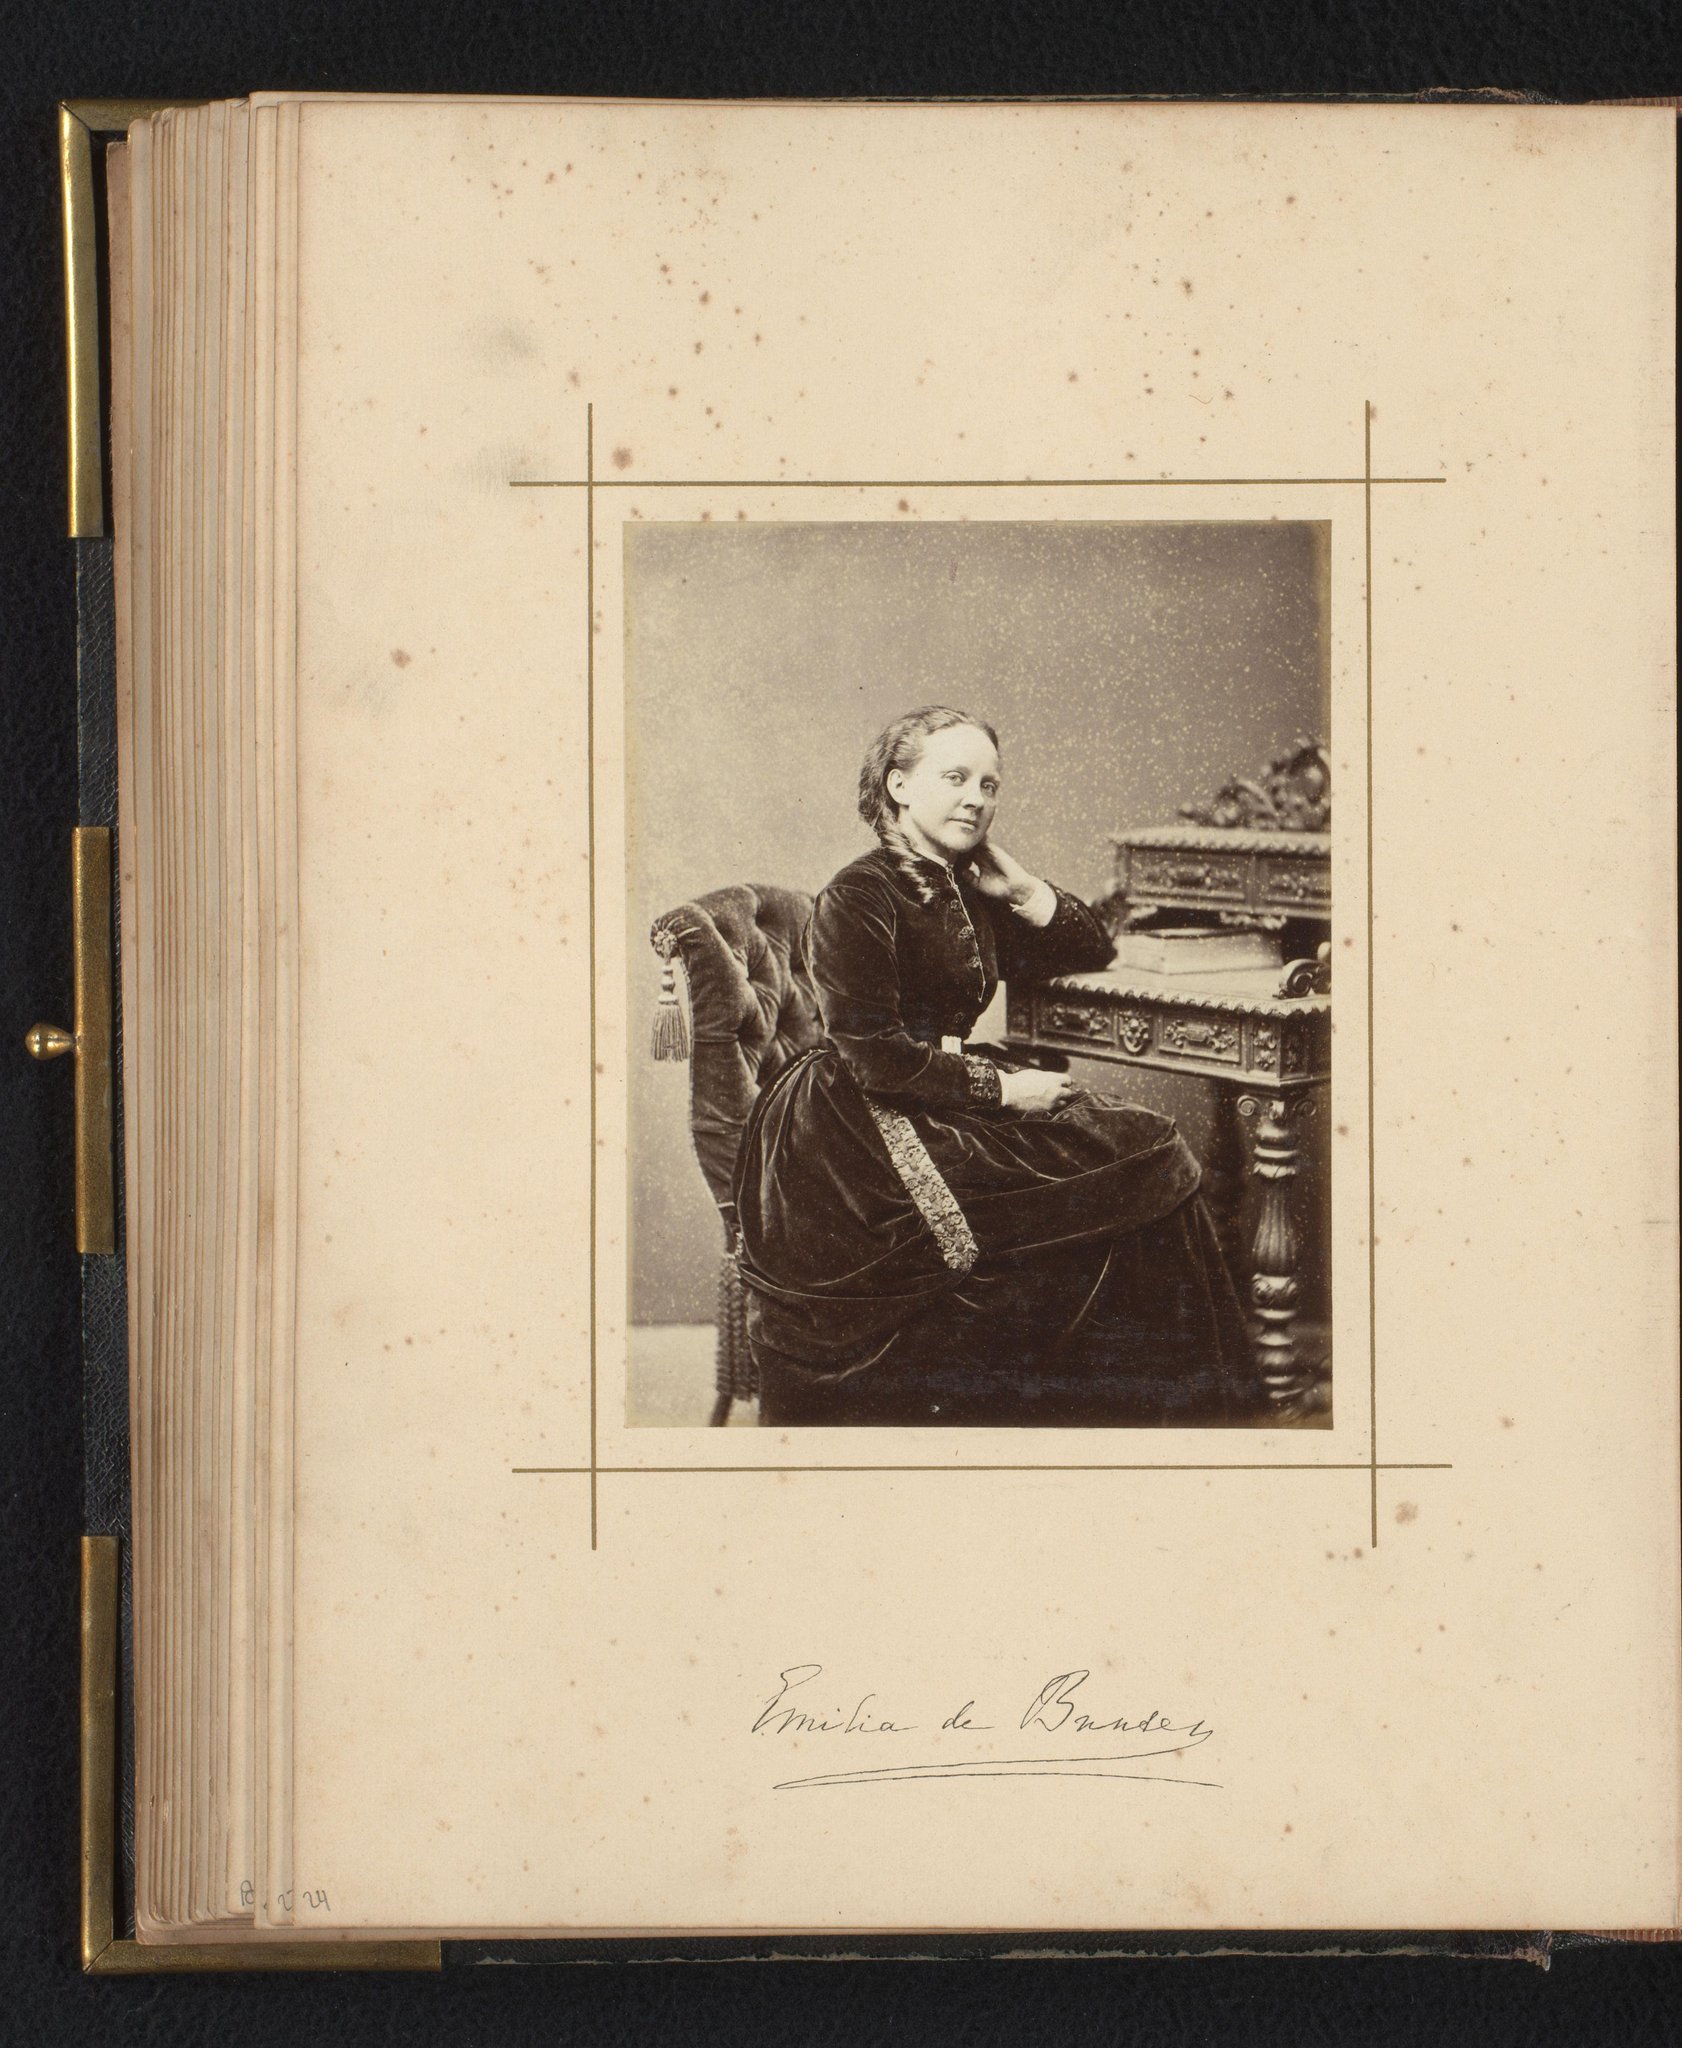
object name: page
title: Portret van Emilia de Bander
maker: Anonymous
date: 1866-1871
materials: photographic support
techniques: albumen print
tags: sitting figure - aa - female human figure, historical persons - bb - woman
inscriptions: name: ‘Emilia de Bander’